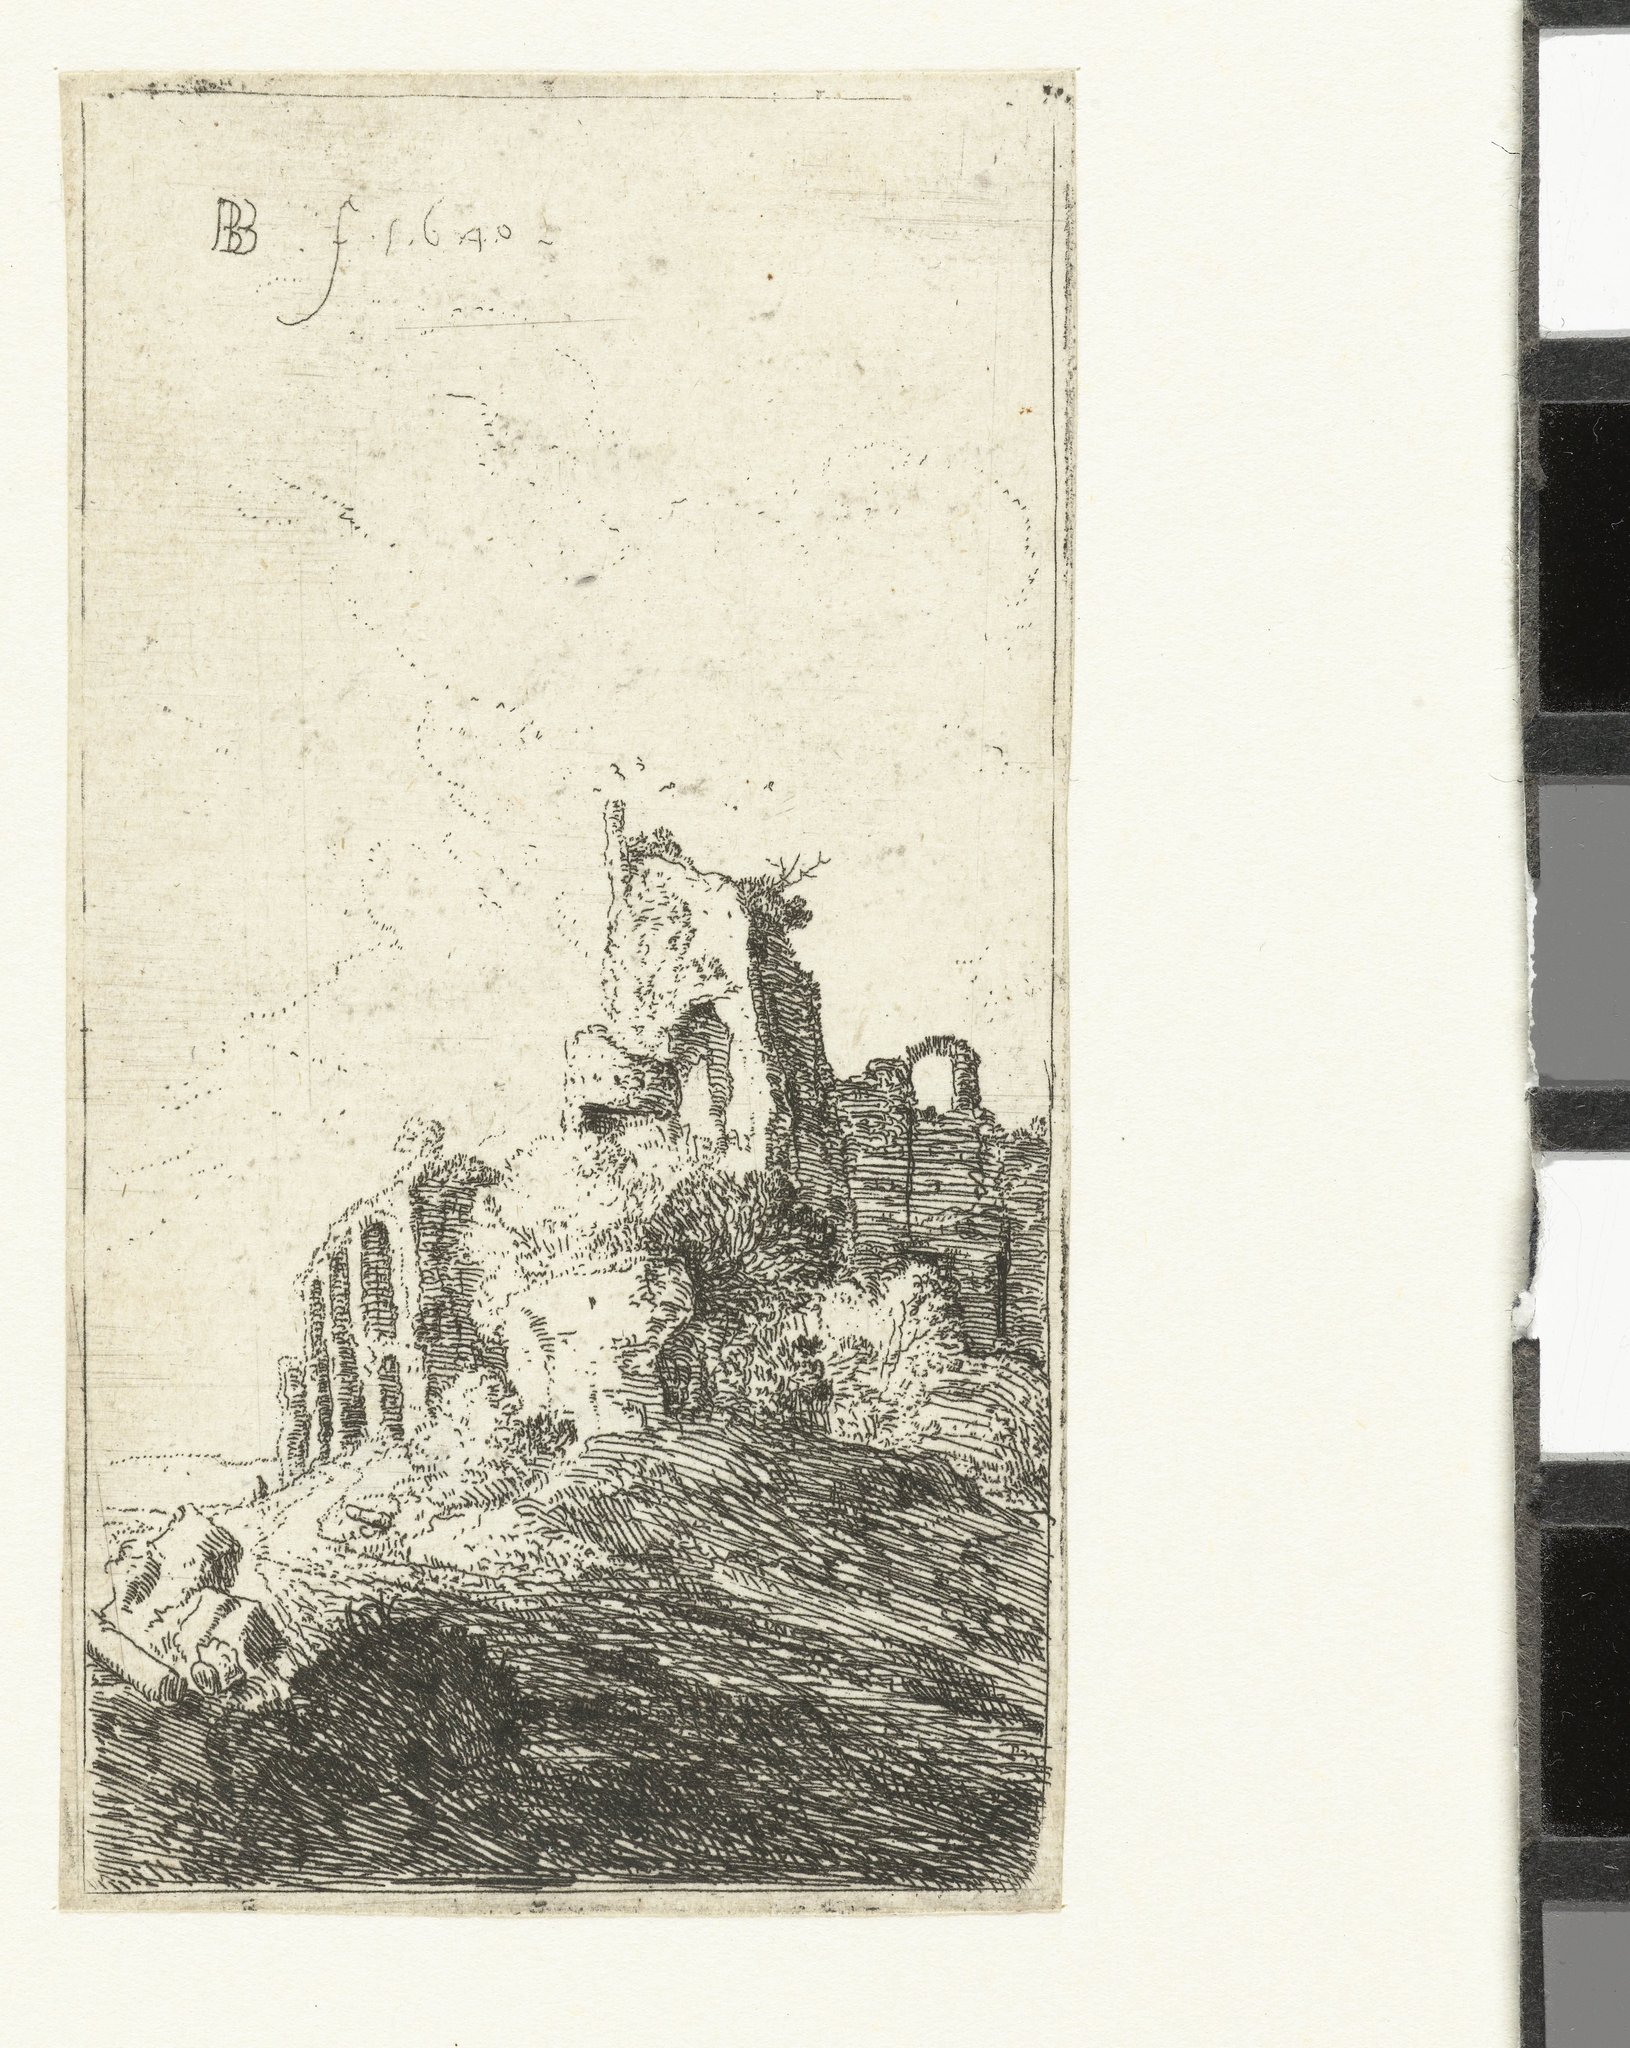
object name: print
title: Ruïnes van keizerlijk paleis te Rome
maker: bartholomeus breenbergh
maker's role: draughtsman, print maker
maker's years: 1599-1657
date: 1640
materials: paper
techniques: etching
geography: netherlands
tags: landscape with ruins, rome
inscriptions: collector's mark: Lugt 240